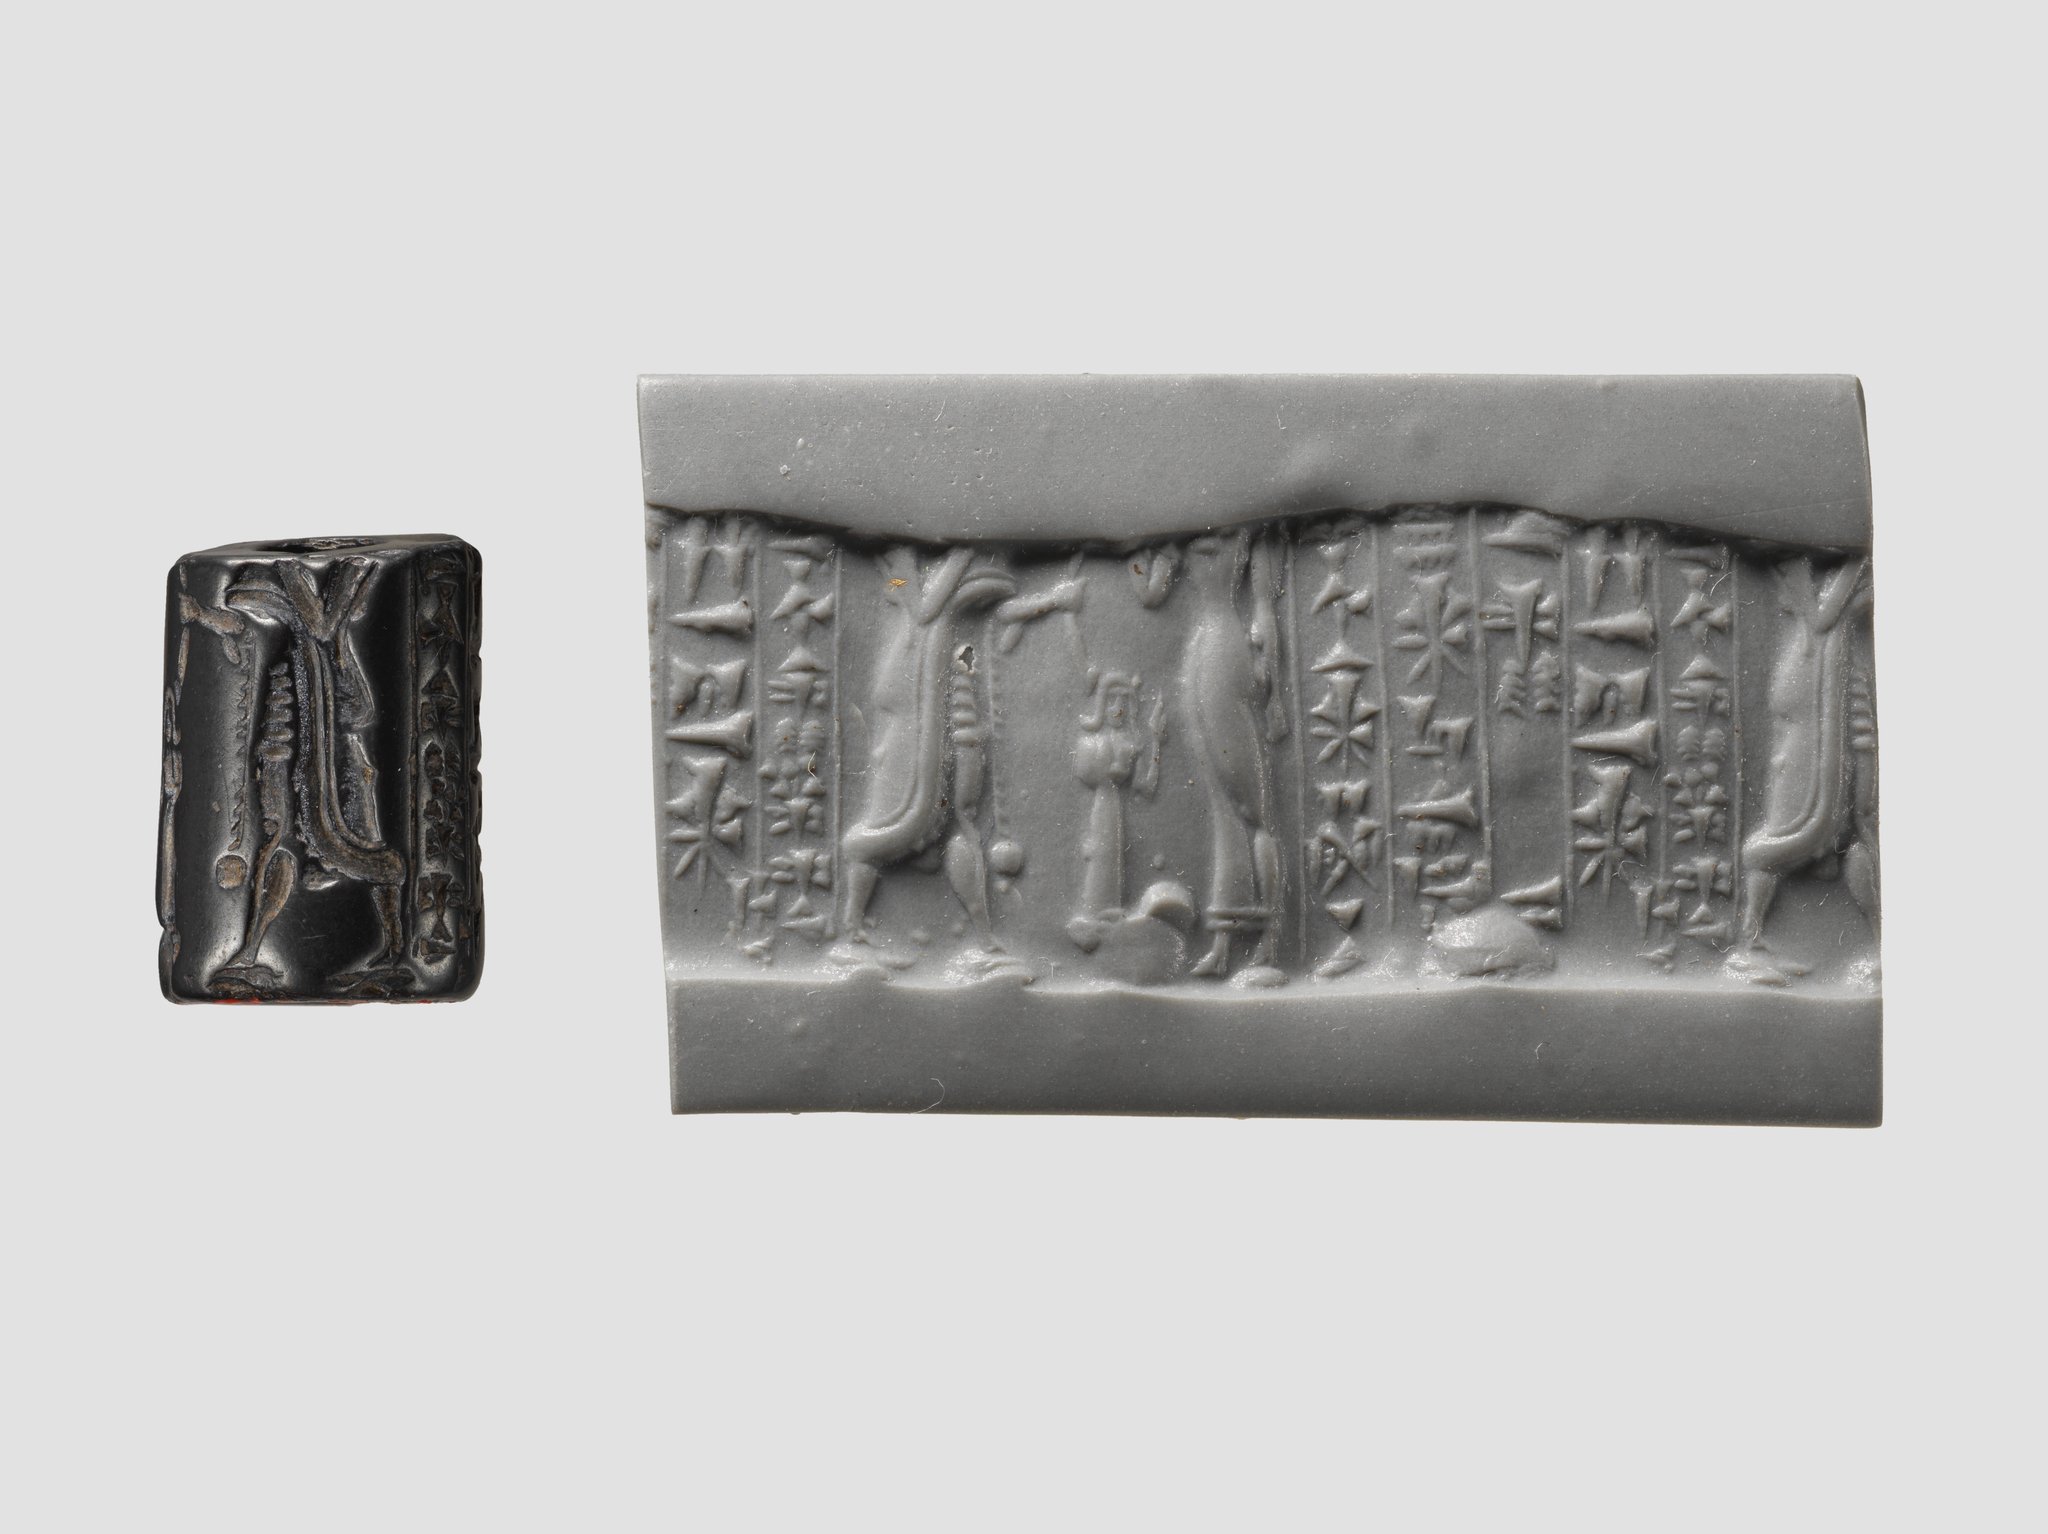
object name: cylinder seal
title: Cylinder seal and modern impression: confronted king and goddess (?), five rows of inscription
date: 1720-1650 BCE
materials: mineral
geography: syria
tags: kings,goddess